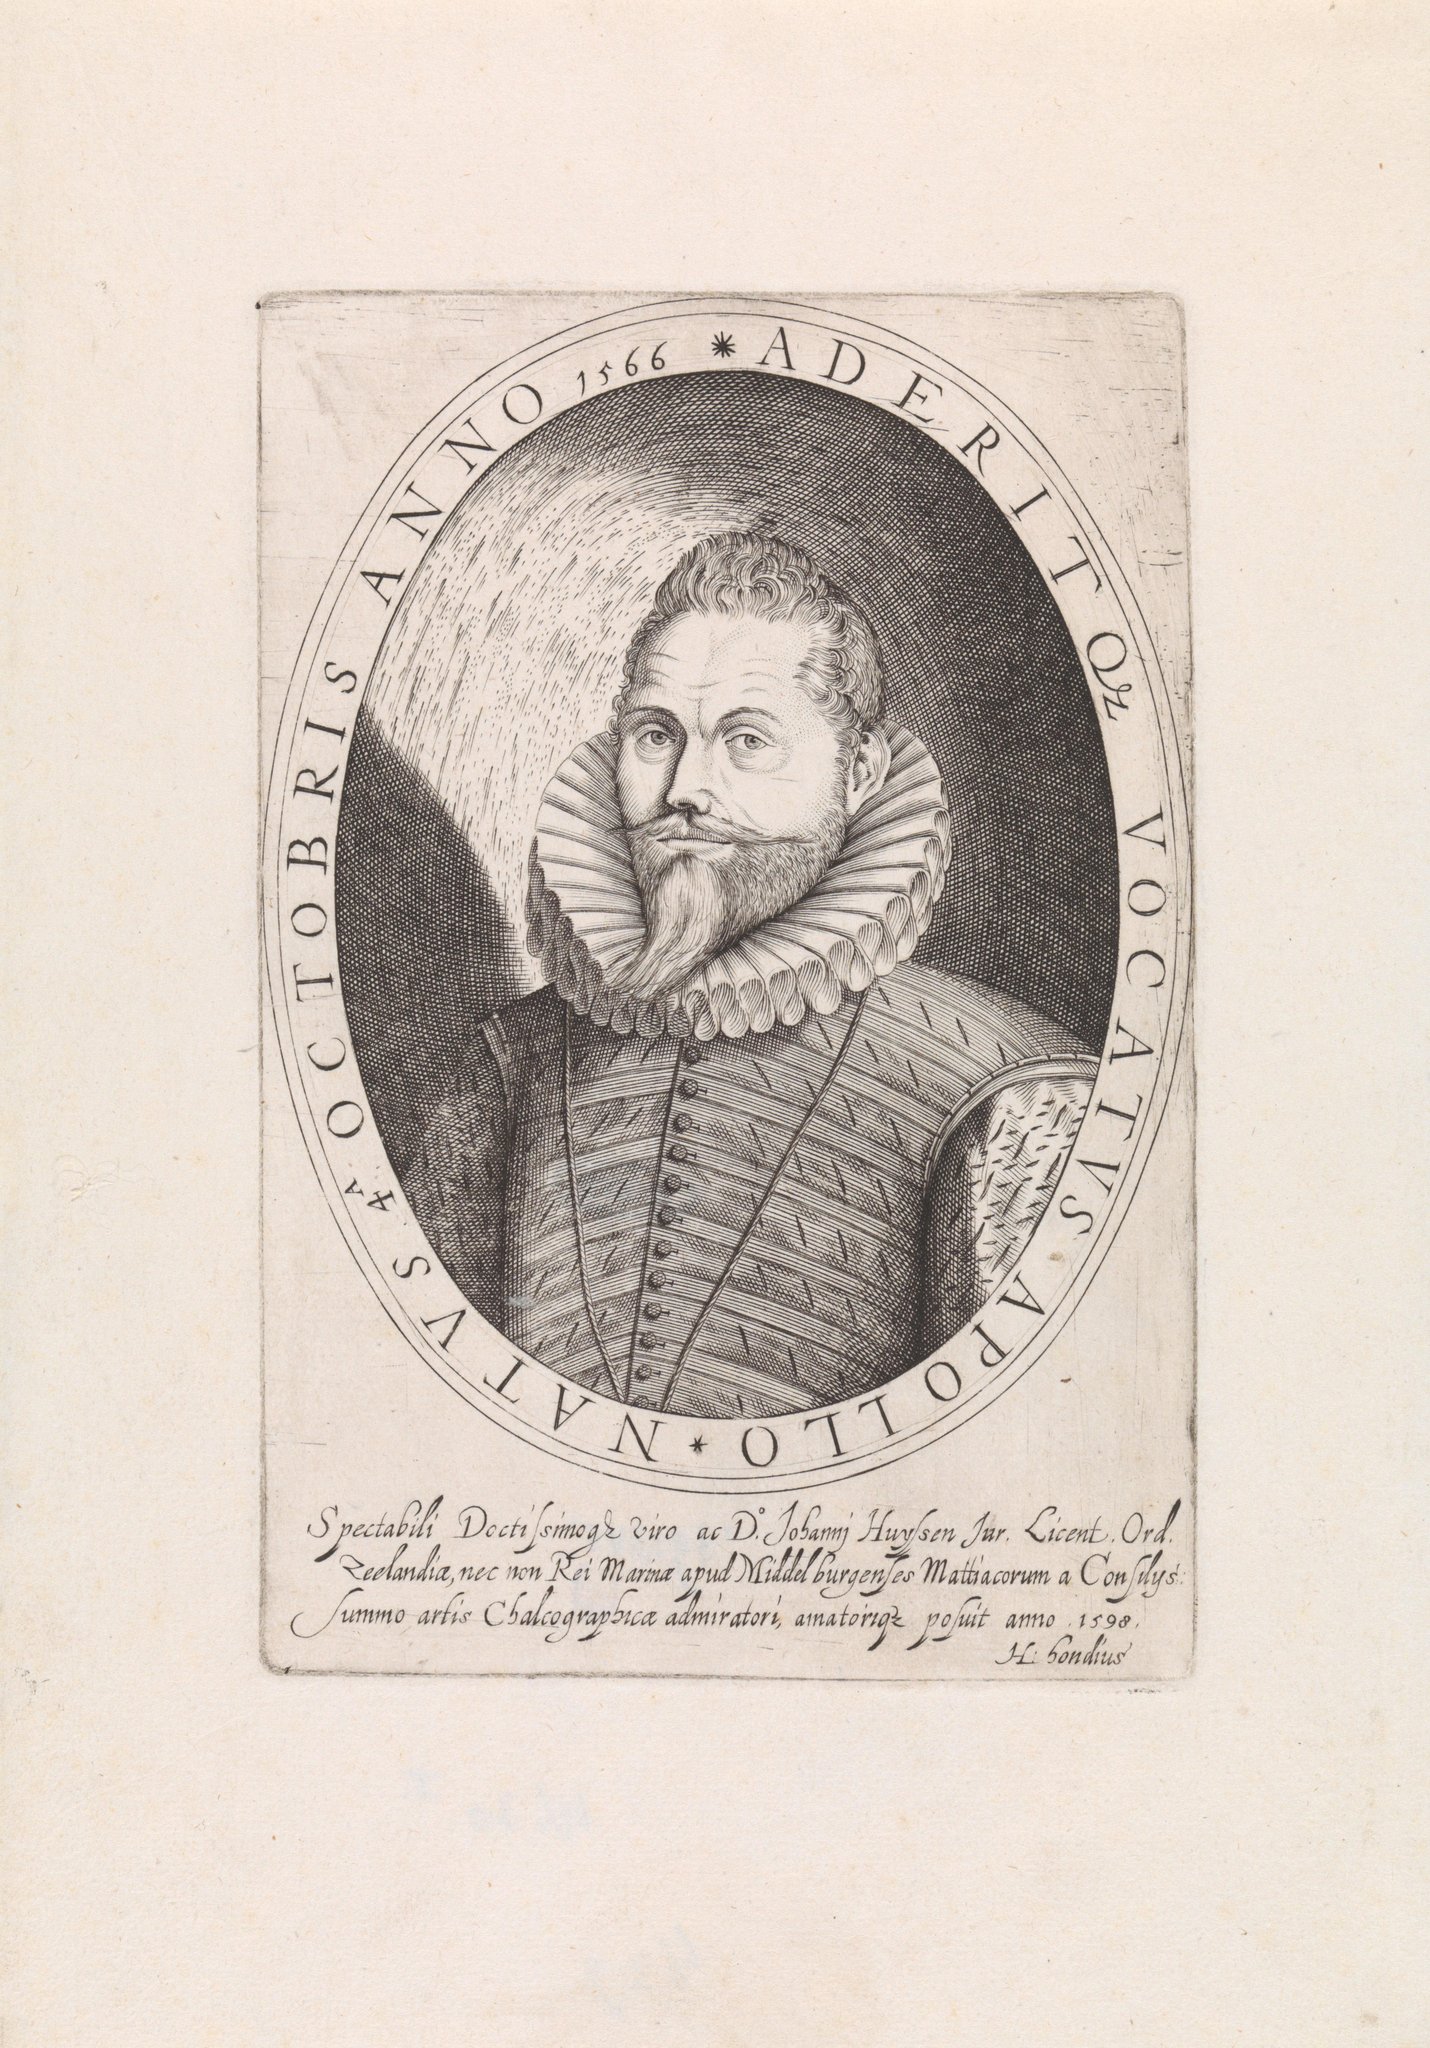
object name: print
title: Portret van Joh. Huijssen van Cattendijck (W.30 I)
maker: hendrick hondius (i)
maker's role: draughtsman, print maker, publisher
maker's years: 1573-1650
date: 1583-1650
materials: paper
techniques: engraving